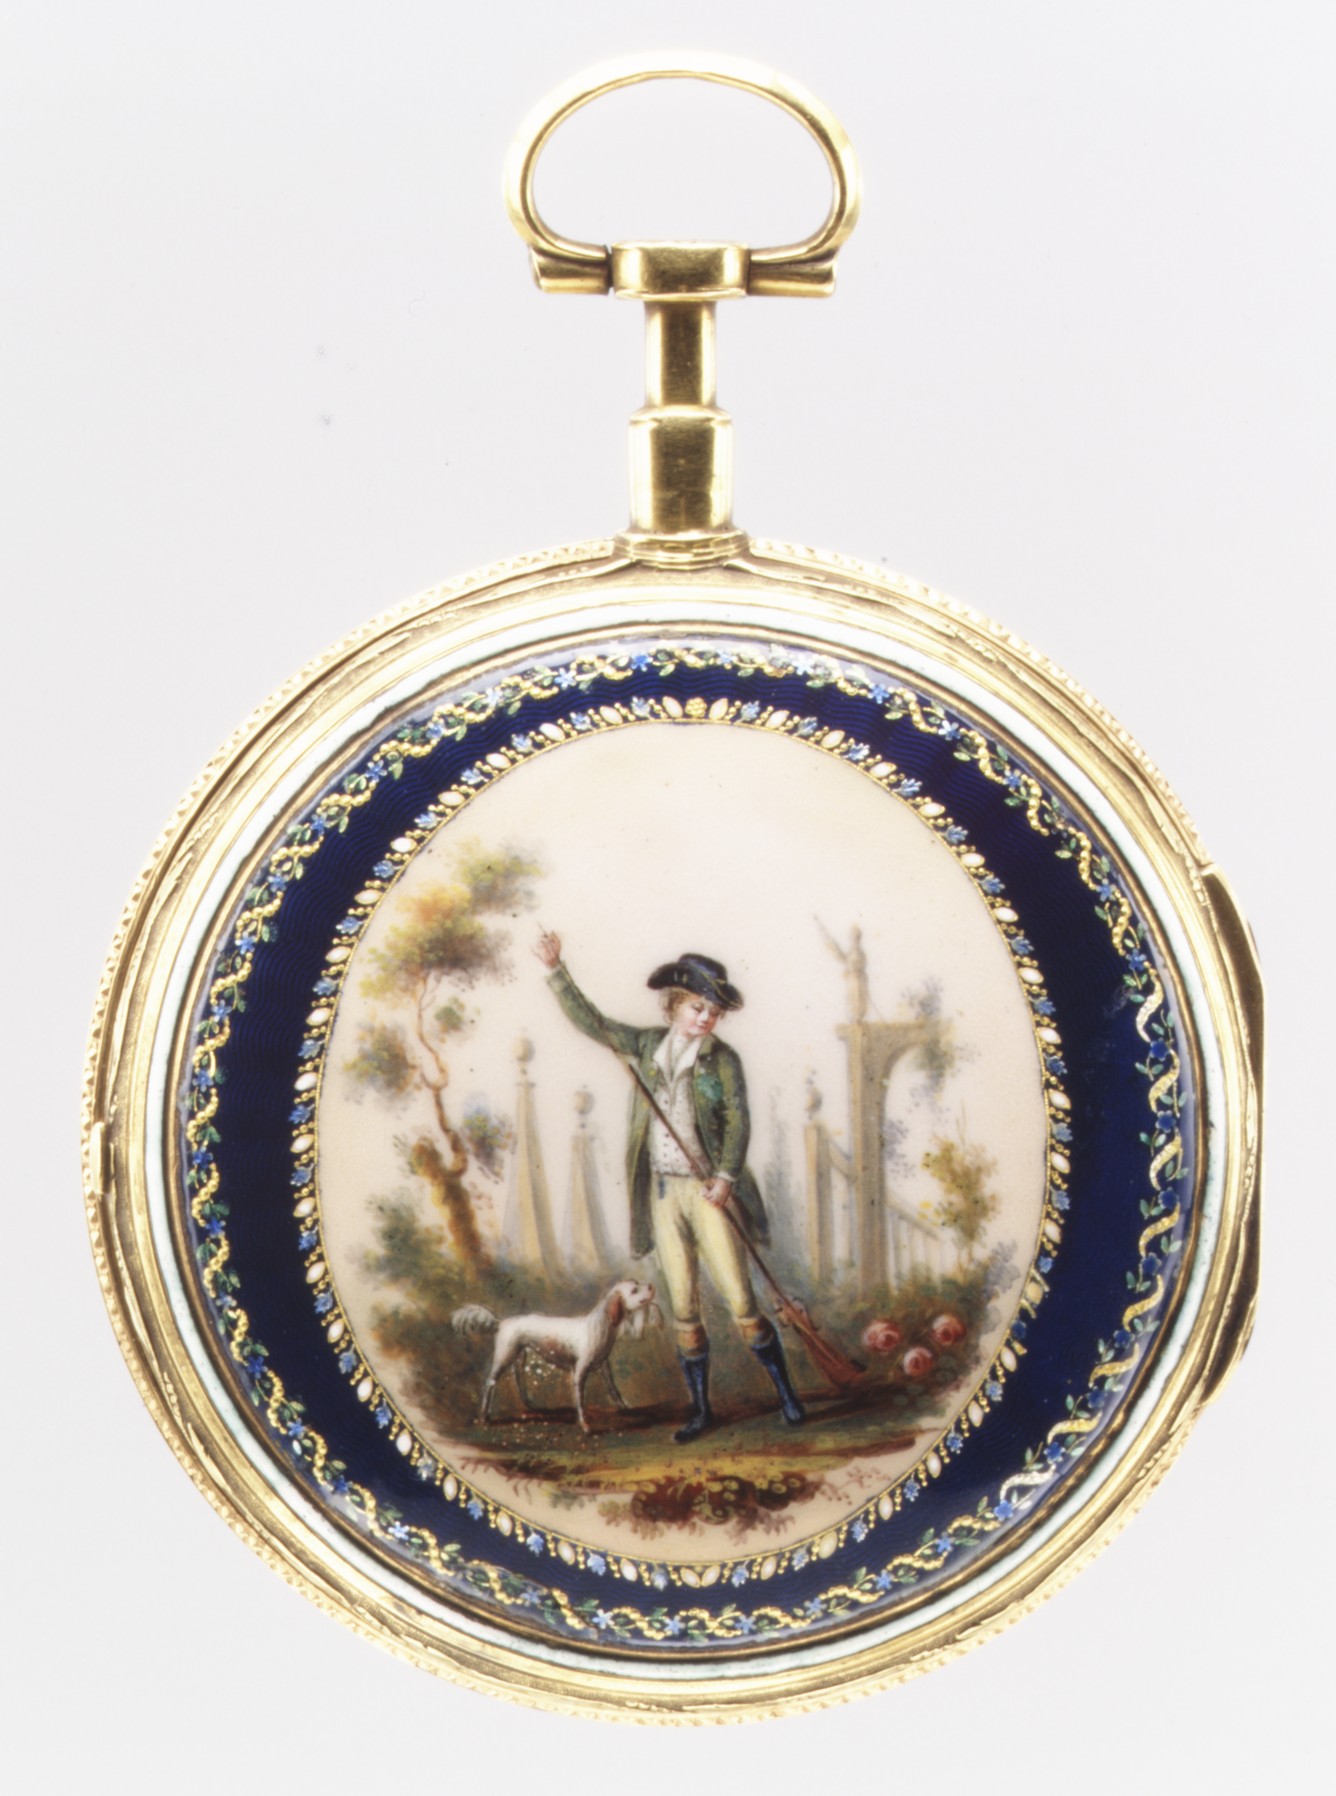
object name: watch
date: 1767-1800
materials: enamel, gold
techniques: painting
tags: men,dogs